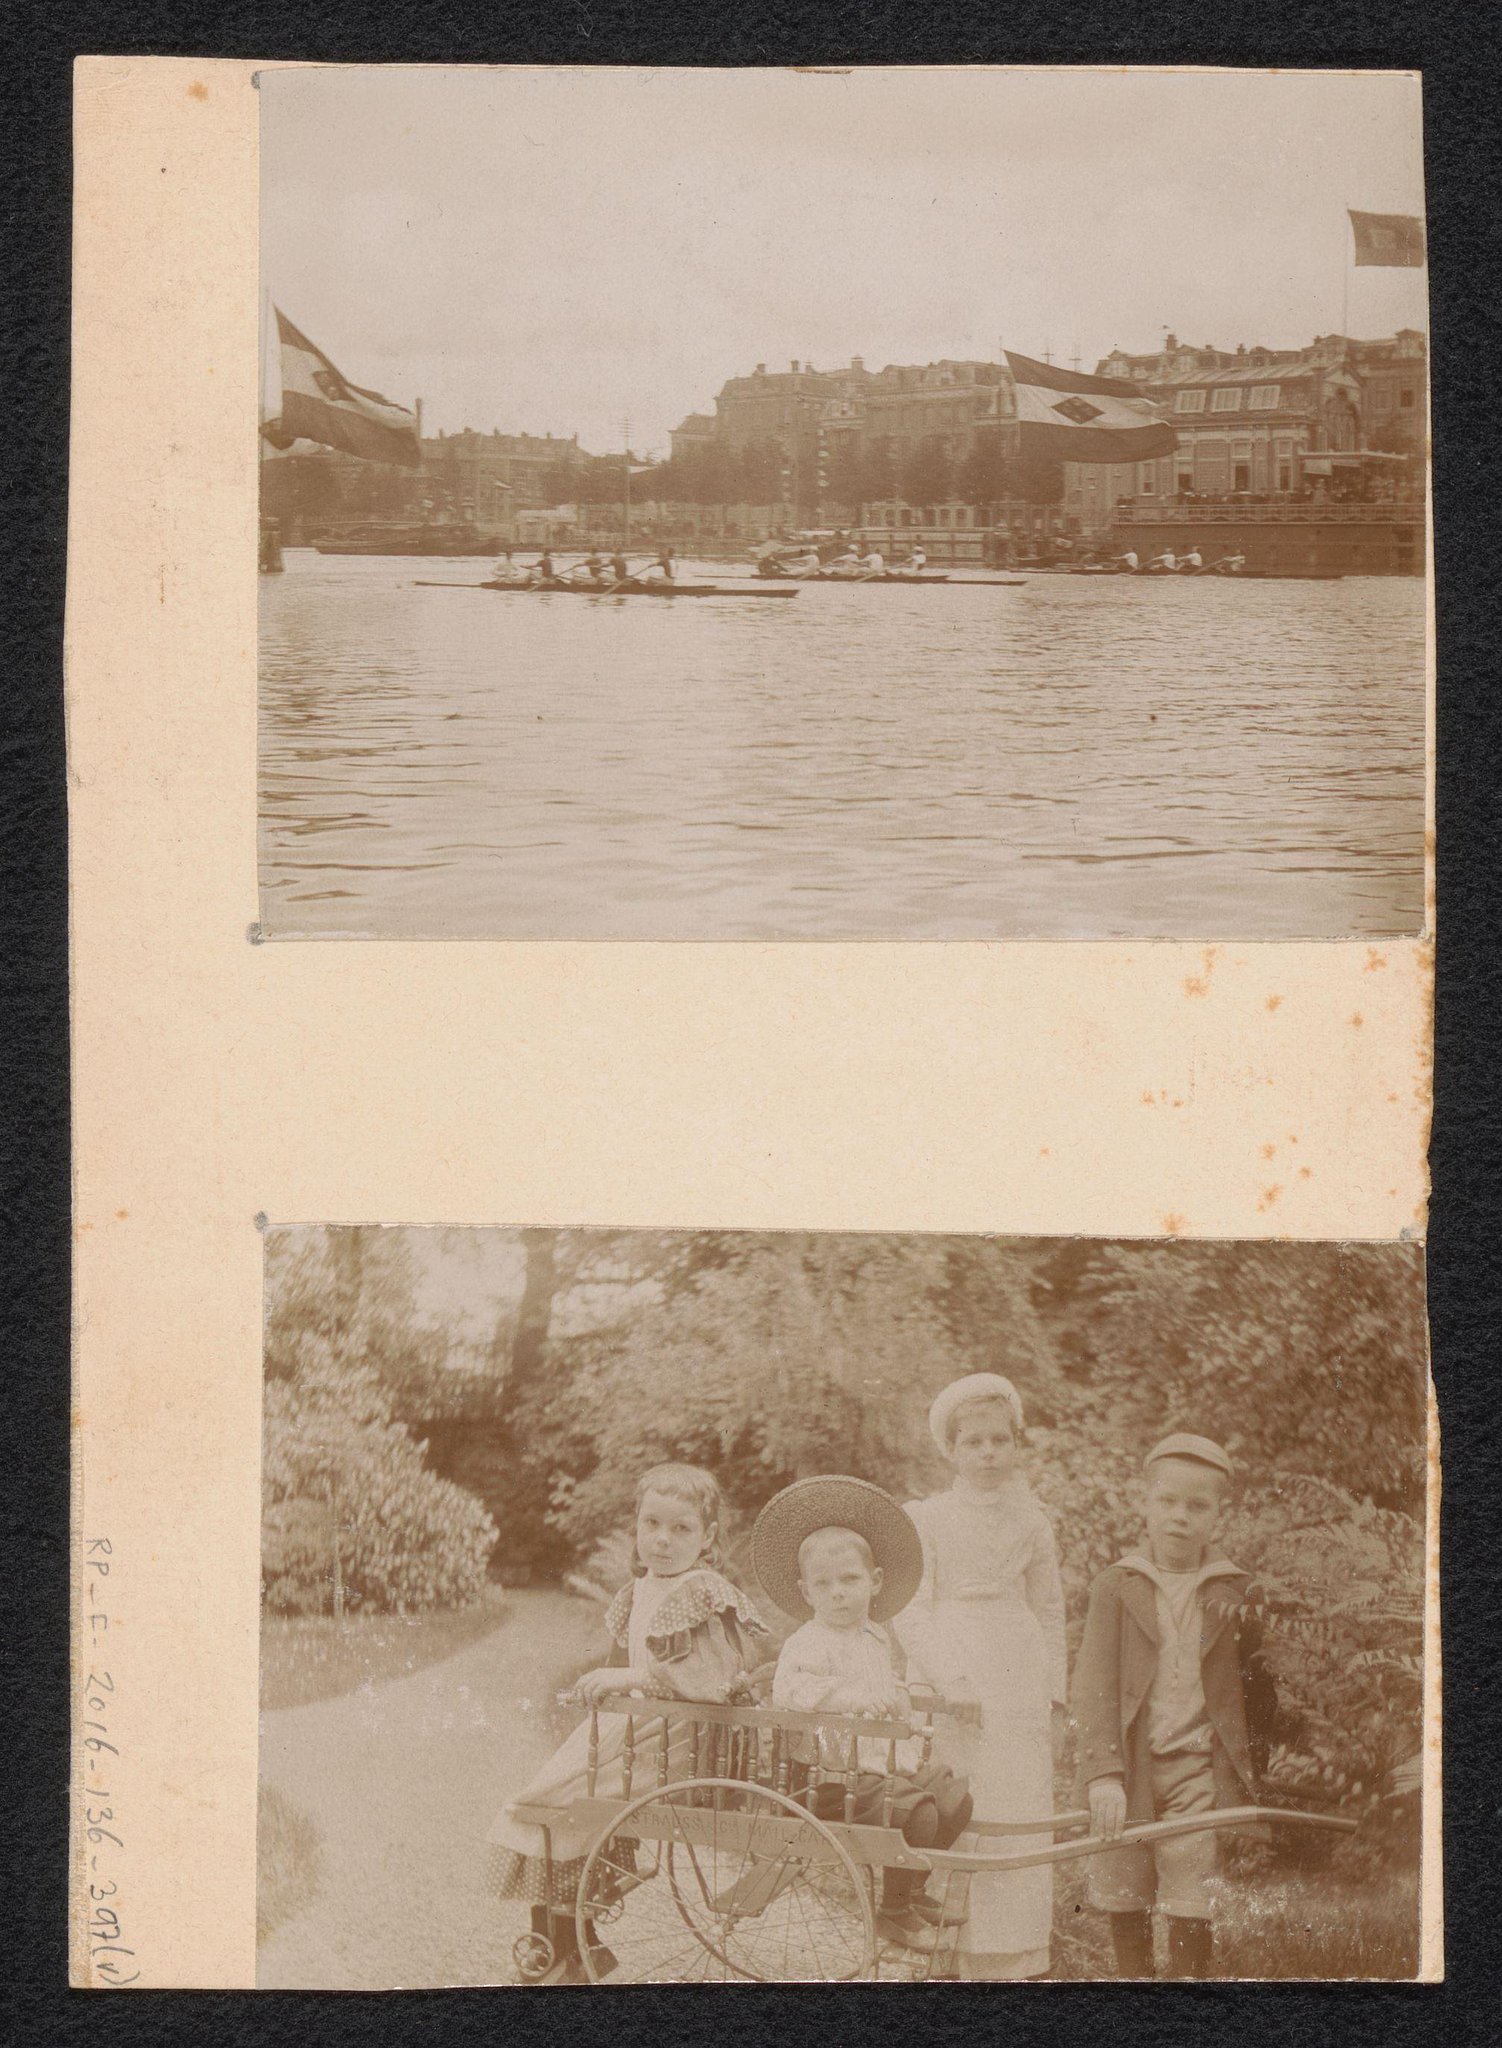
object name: photograph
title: Roeien op de Amstel Amsterdam en groepje van vier kinderen met kar in de tuin van Turfmarkt 3, Amsterdam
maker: hendrik herman van den berg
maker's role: amateurfotograaf, jurist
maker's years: 1875-1944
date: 1890-1894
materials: cardboard, photographic support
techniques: collodion silver print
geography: amsterdam